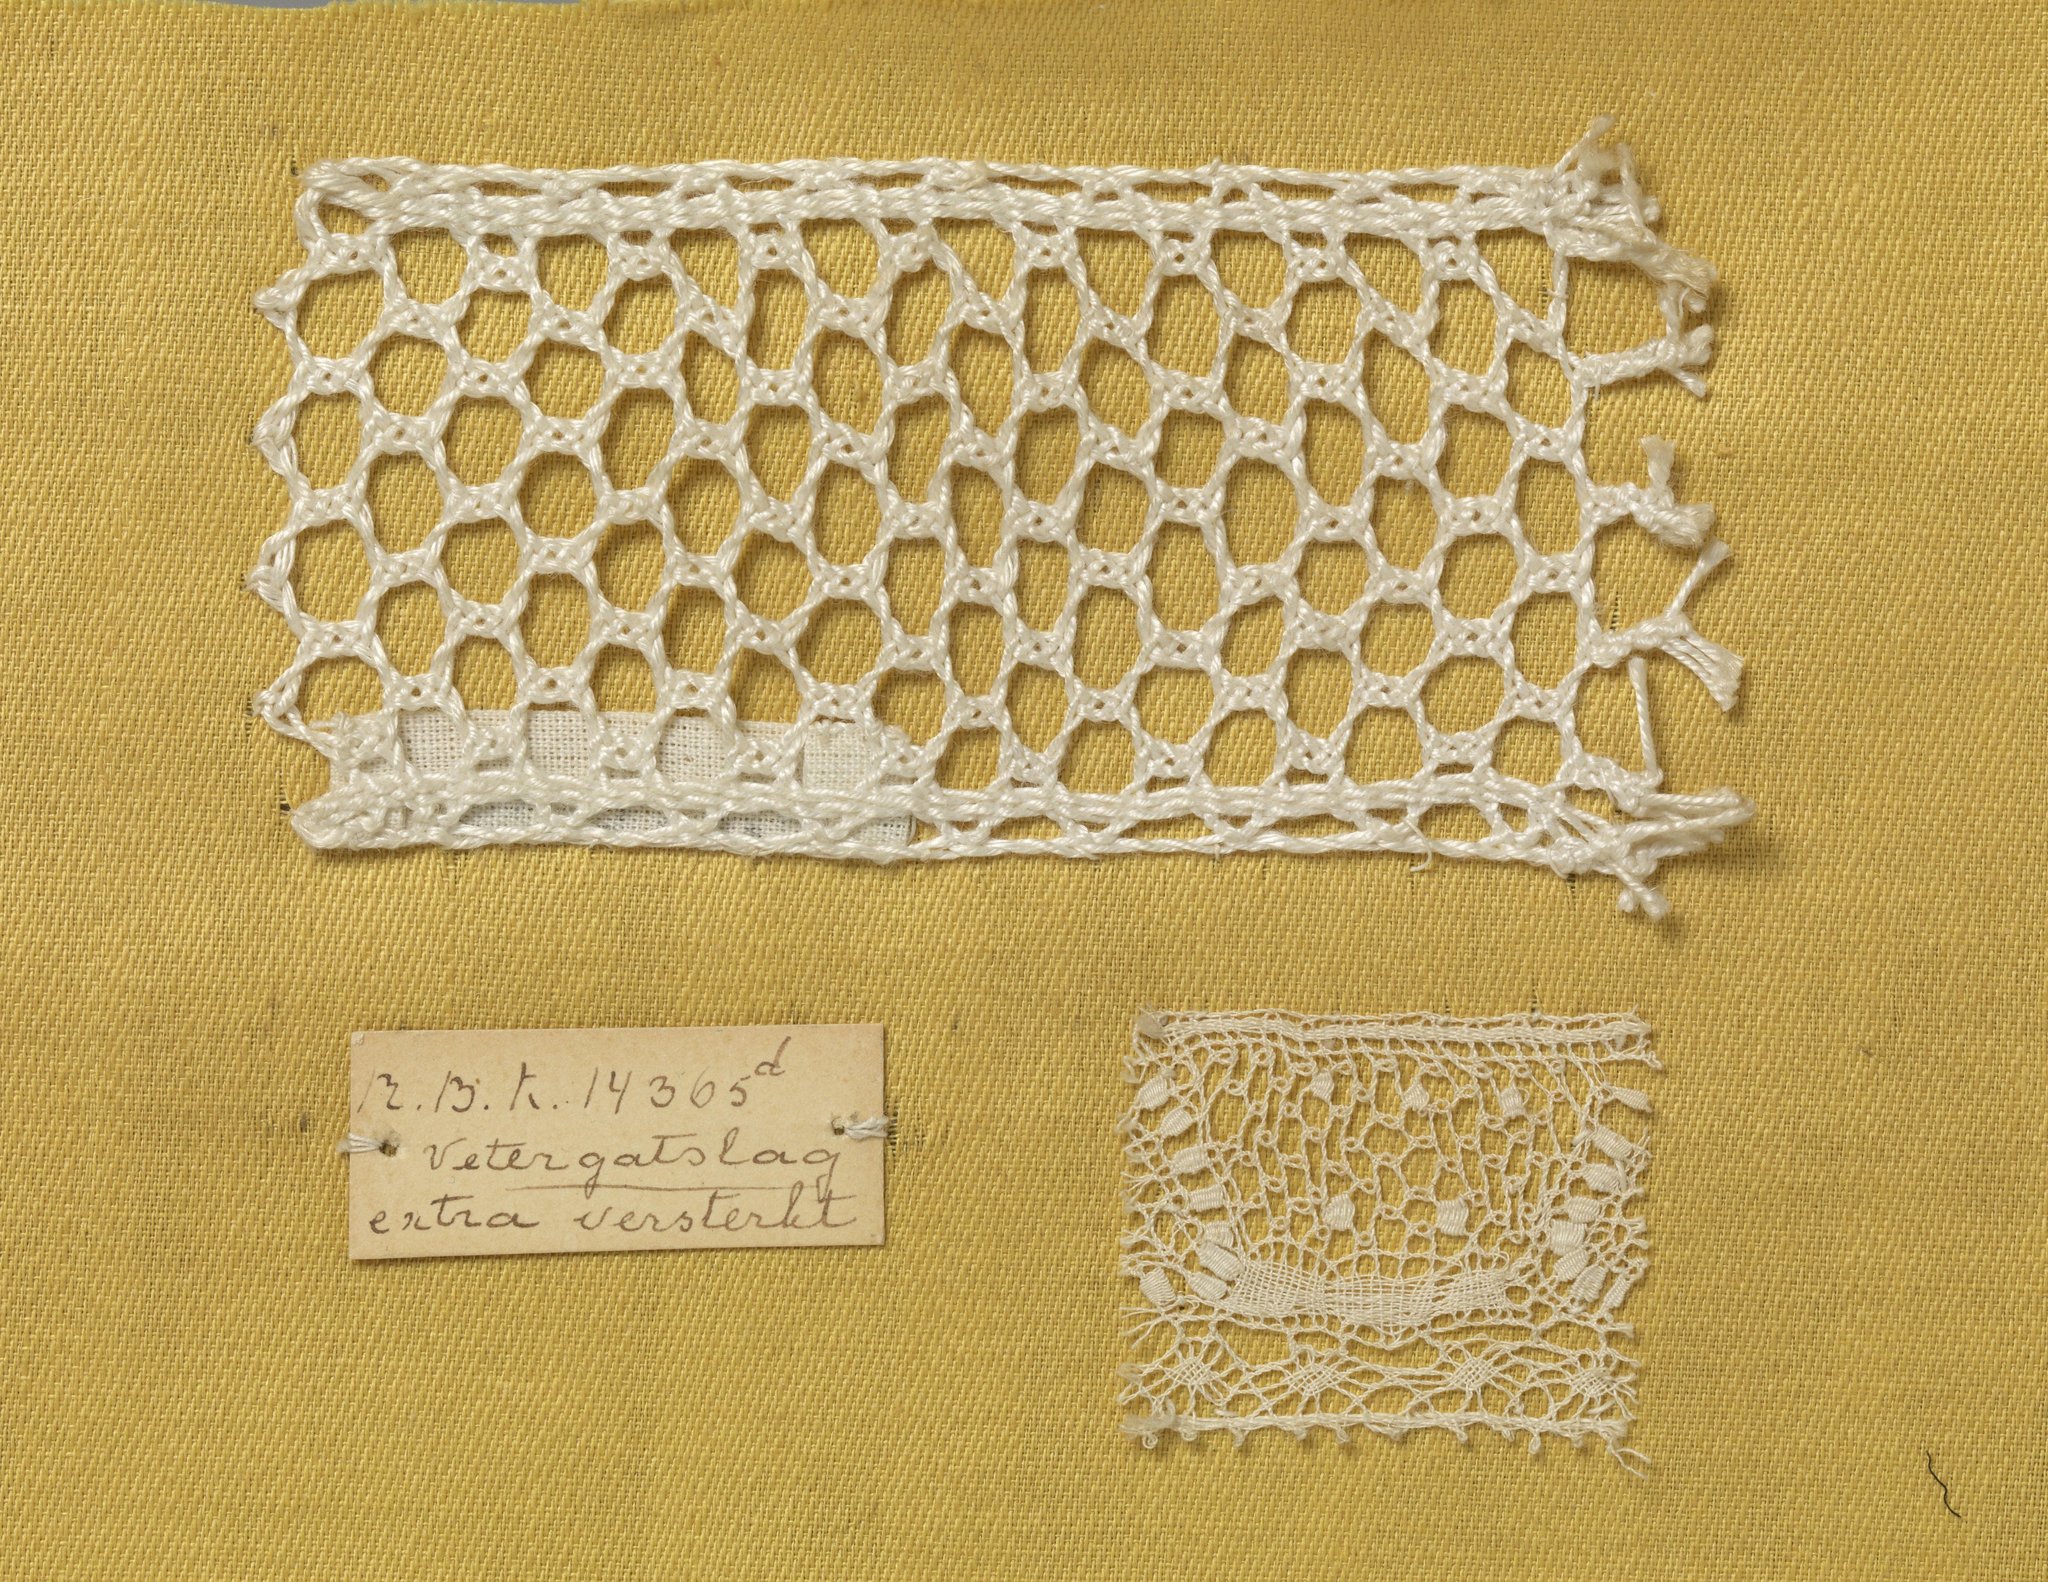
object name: sample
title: Staal kloskant met grove draad als voorbeeld van extra versterkte stroptraliegrond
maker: Anonymous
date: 1900-1930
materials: cotton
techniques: lace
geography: amsterdam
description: Staal naturelkleurige kloskant met grove draad als voorbeeld van een extra versterkte stroptraliegrond met daarbij een fragment kant waarin deze techniek is toegepast. De datering betreft het staal.